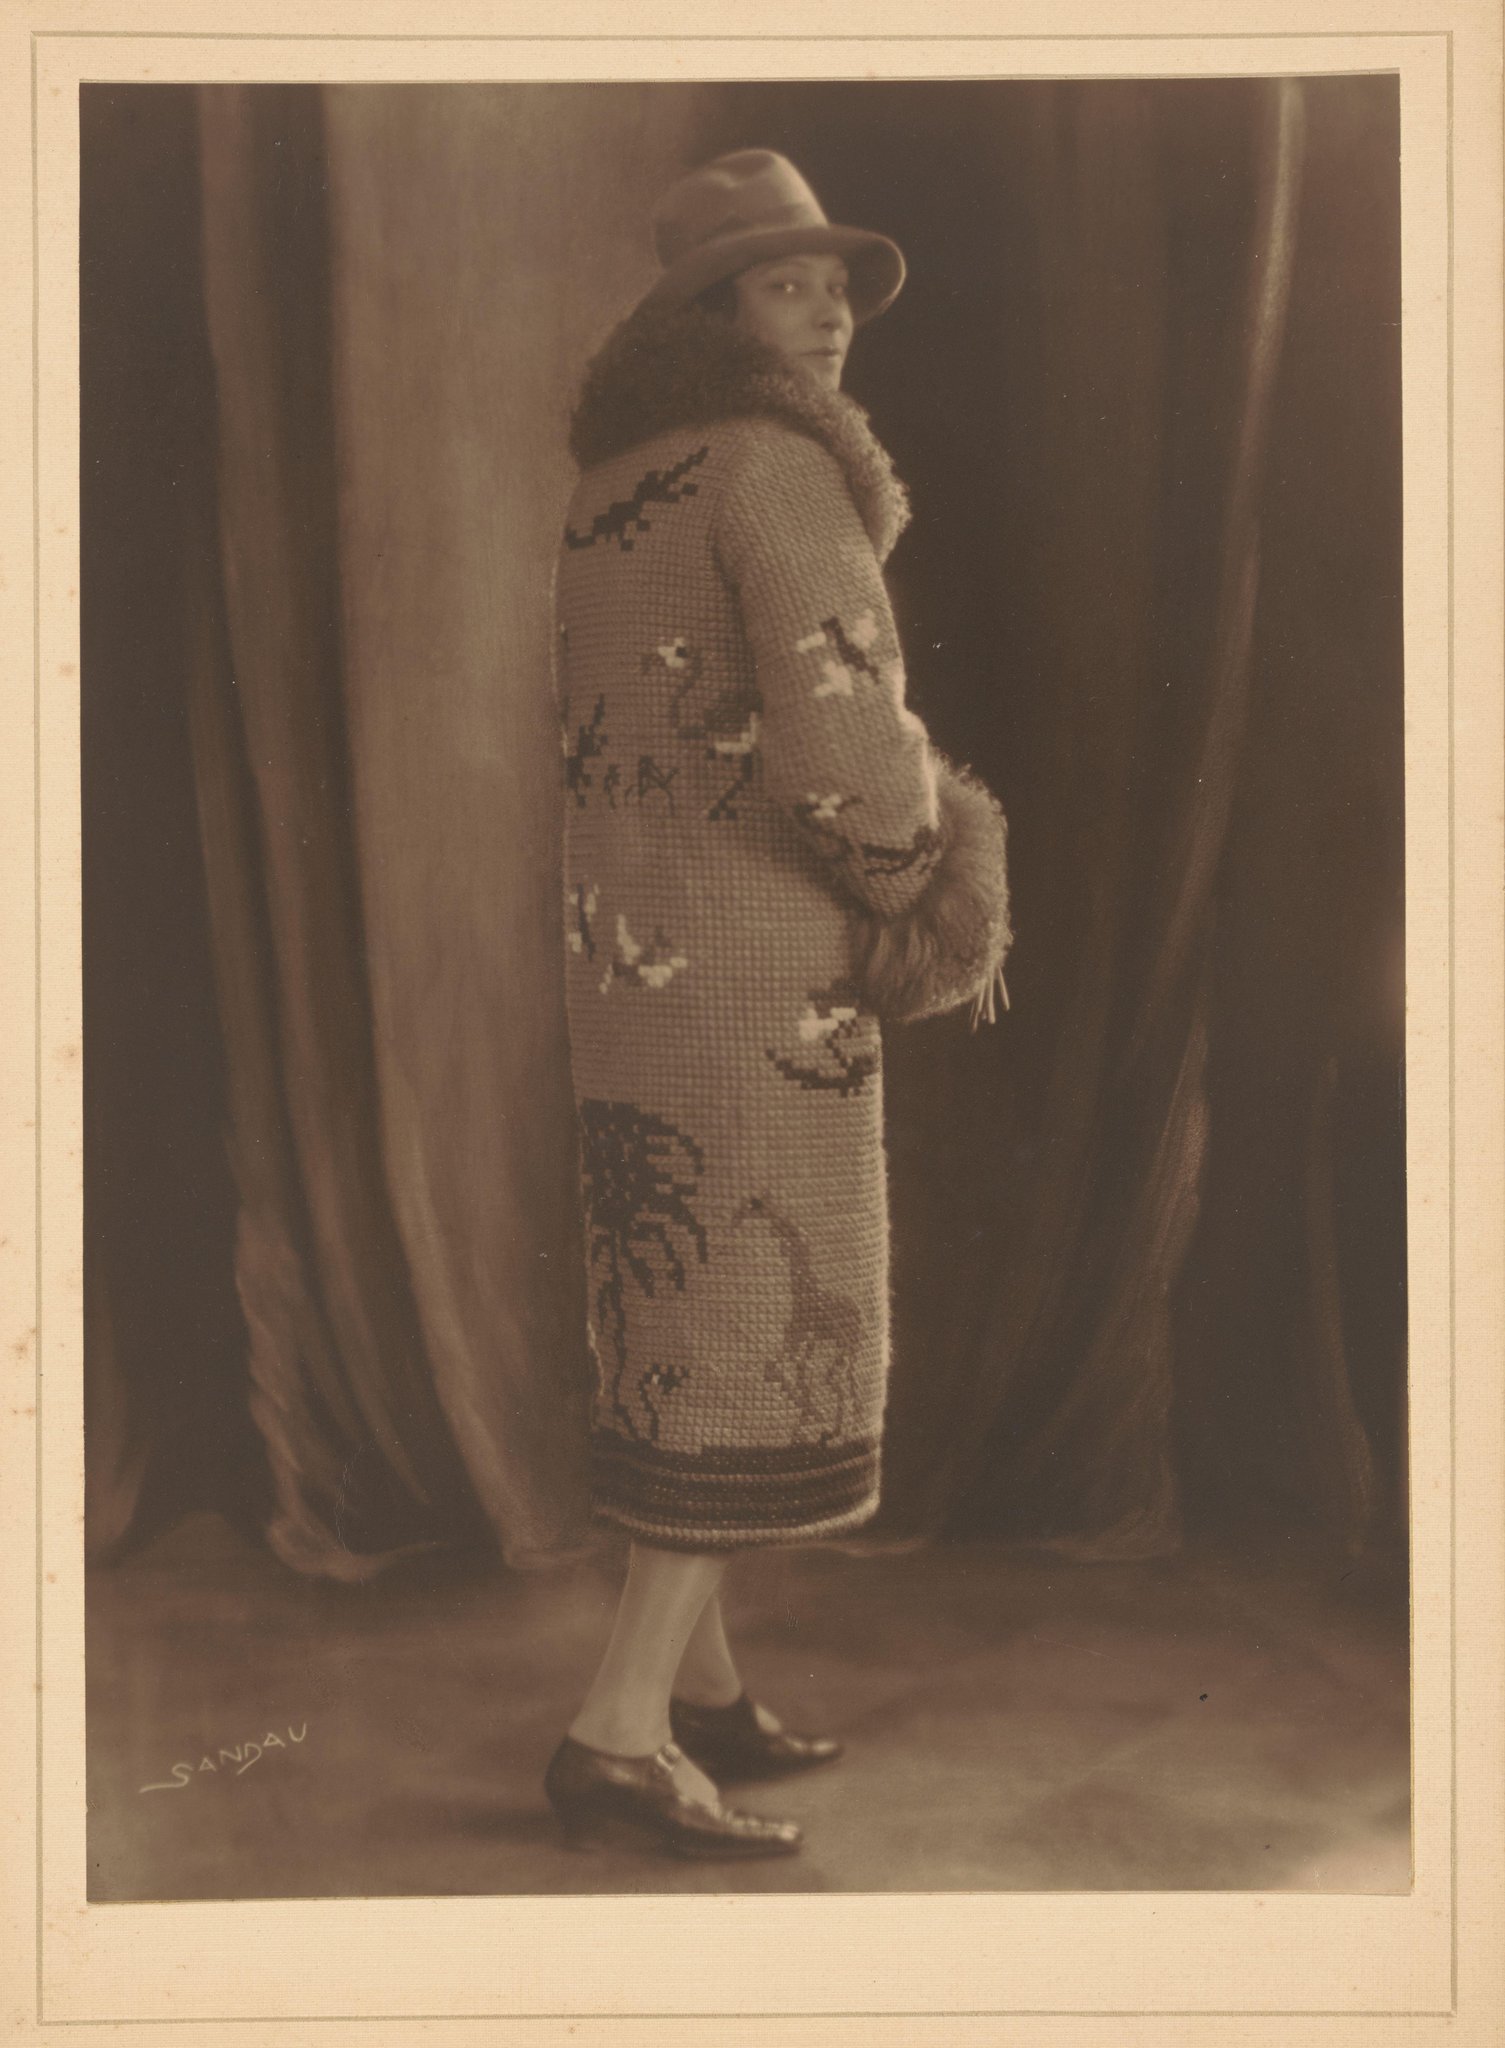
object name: photograph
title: Portret van een onbekende vrouw, mogelijk een Duitse actrice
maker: ernst sandau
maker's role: fotograaf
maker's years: 1880-1918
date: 1910-1918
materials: paper, cardboard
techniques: gelatin silver print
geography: germany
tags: anonymous historical person portrayed - bb - woman, berlin